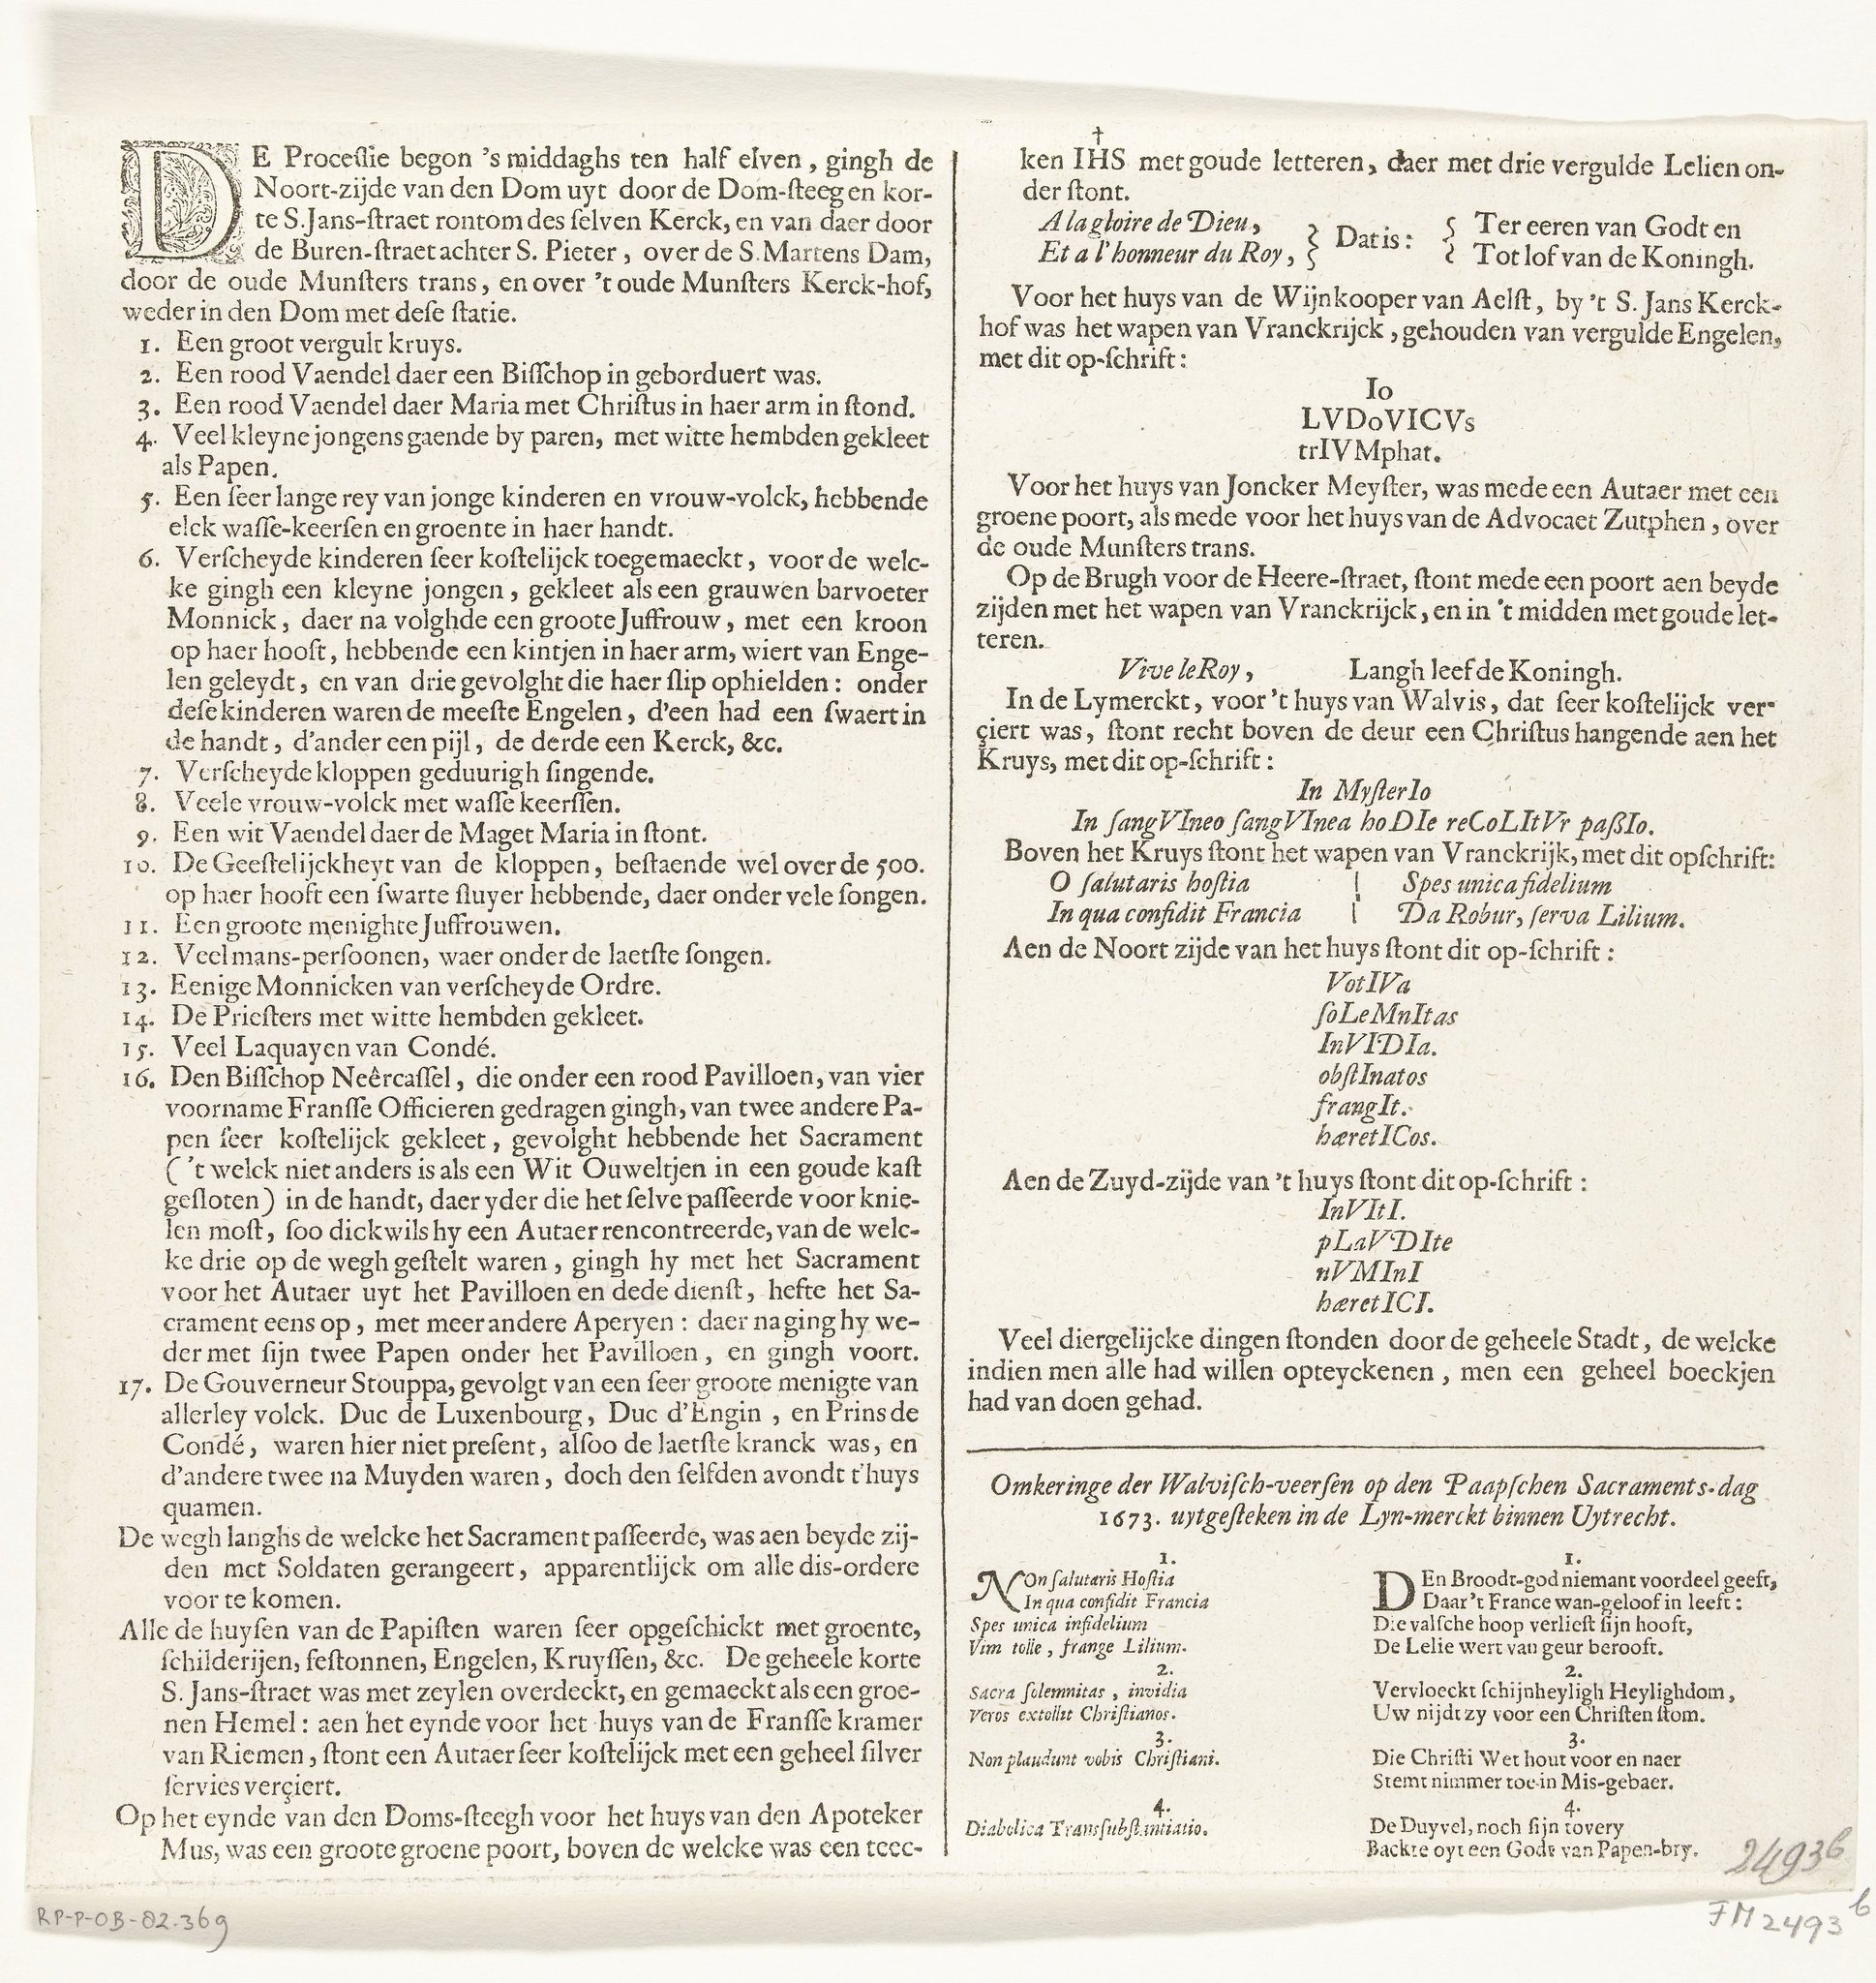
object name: text sheet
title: Tekst bij een prent van de Roomse processie te Utrecht, 1673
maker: jan claesz ten hoorn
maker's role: publisher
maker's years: 1638-1715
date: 1673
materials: paper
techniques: letterpress printing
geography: amsterdam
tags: priest, utrecht, battle of the texel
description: Tekstblad behorend onder een prent met een voorstelling van de Roomse sacramentsprocessie gehouden te Utrecht op Sacramentsdag, 22 augustus 1673 (een verzonnen datum, wellicht verwijzend naar de overwinning van de Hollanders in de zeeslag bij Kijkduin op 21 augustus 1673). Tekst in 2 kolommen waarin de gebeurtenis beschreven wordt en de legenda 1-17. Op het eind het spotvers: Omkeringe der walvisch-veersen.